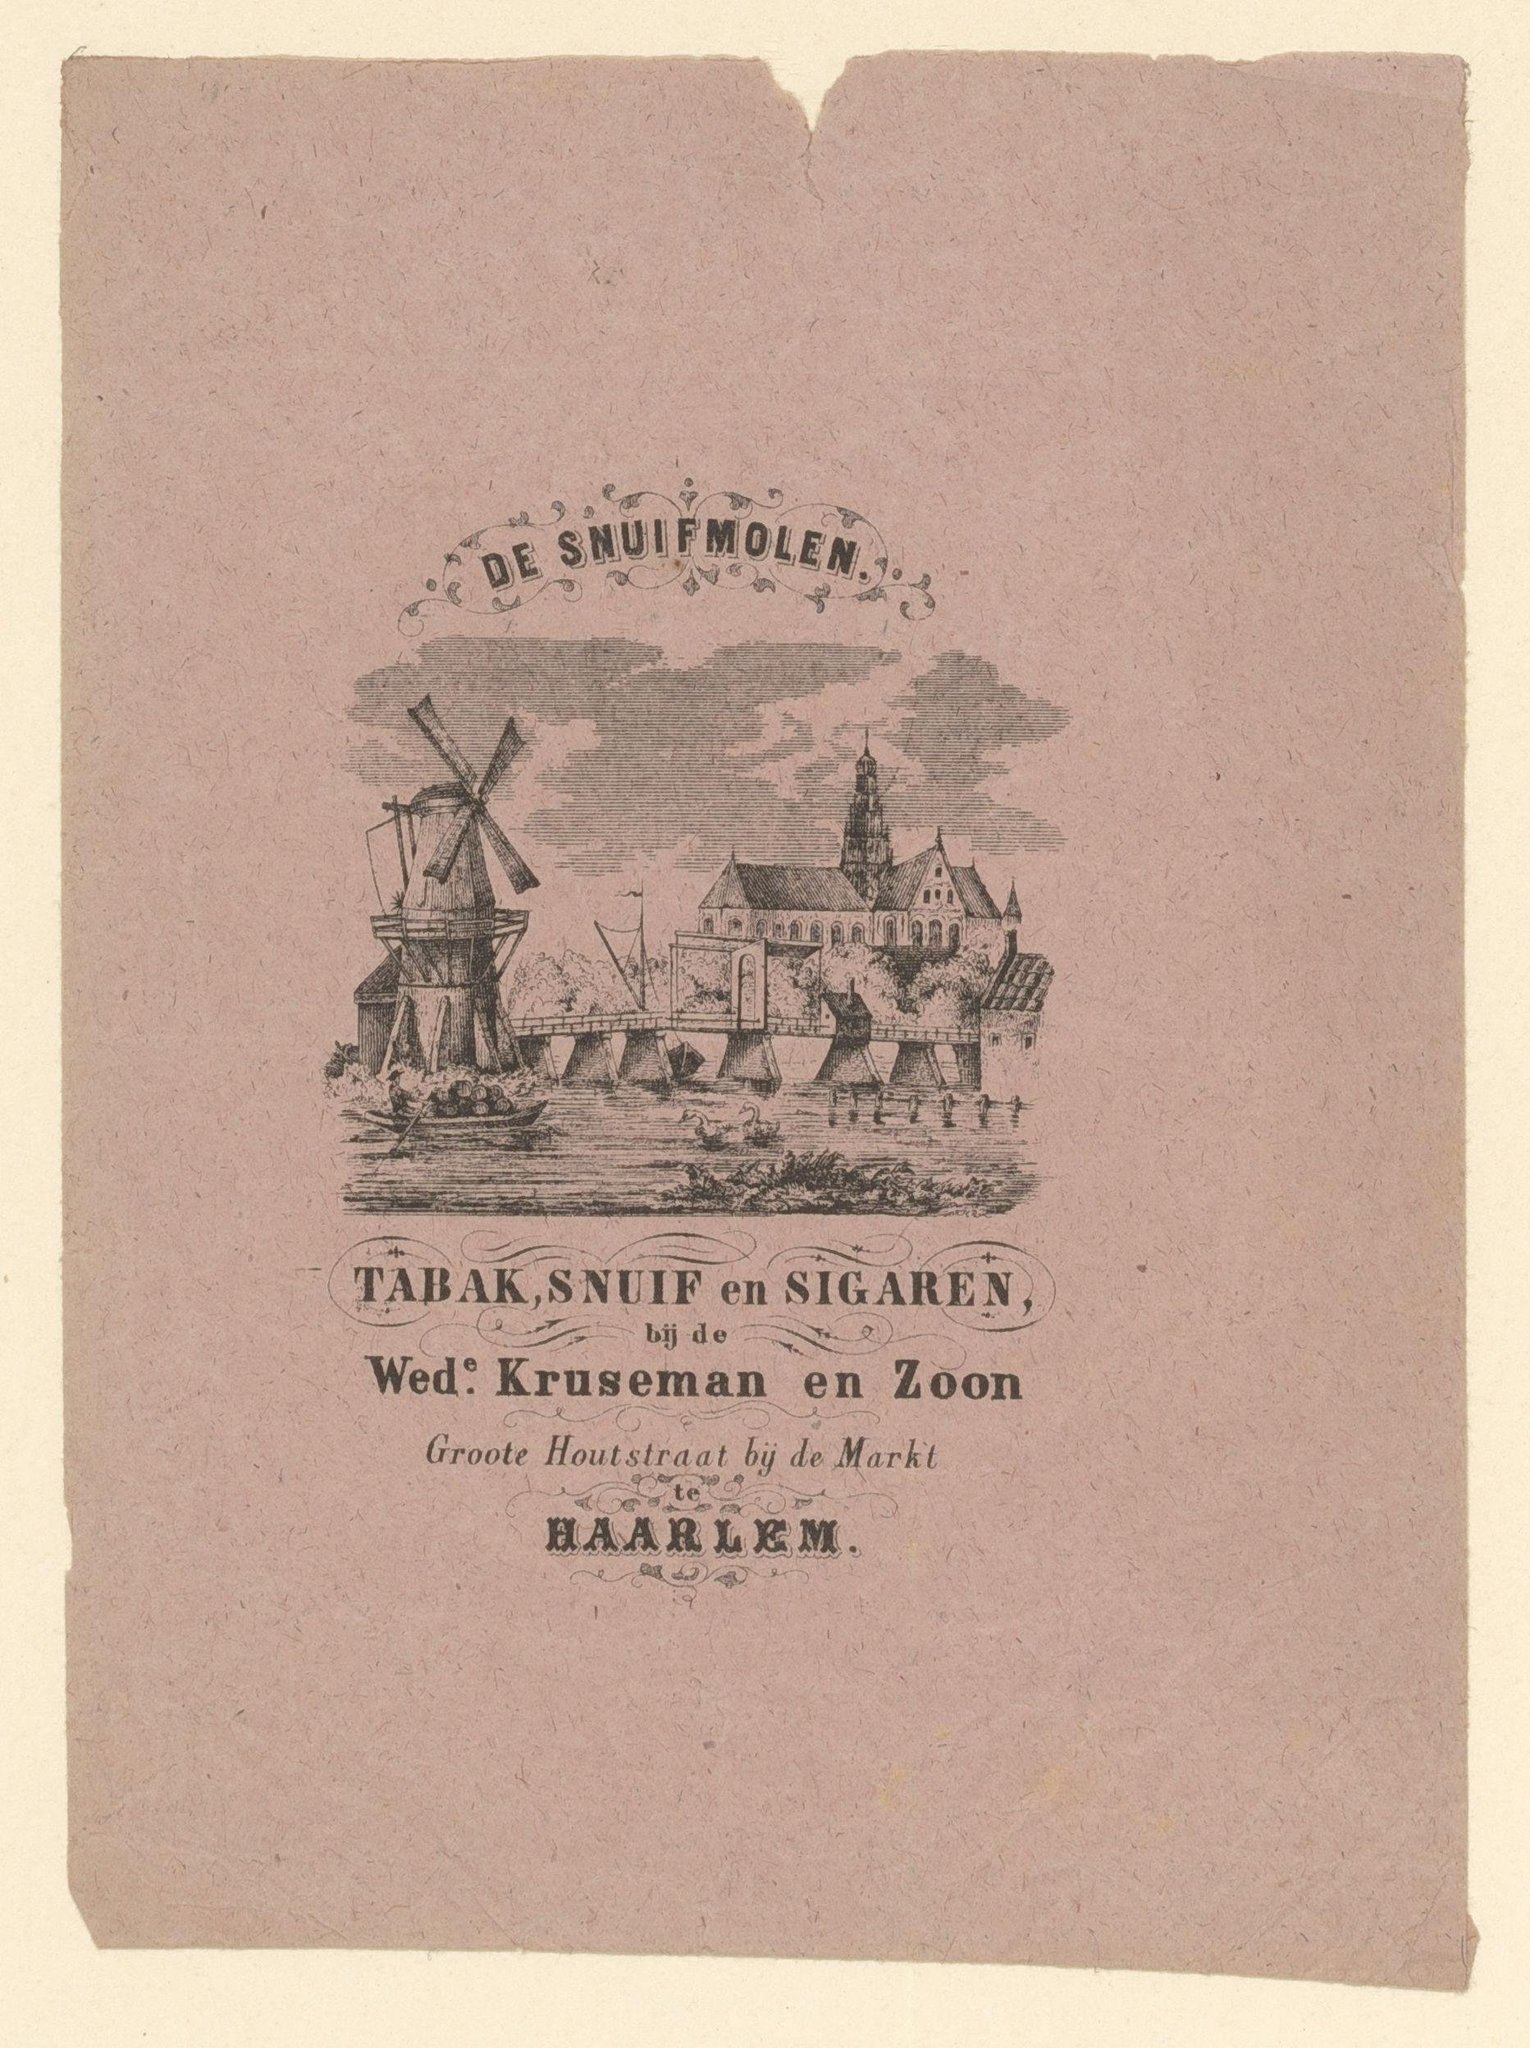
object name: print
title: Etiket voor tabaksverpakking van De Snuifmolen van de Weduwe Kruseman en Zoon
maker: Anonymous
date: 1800-1850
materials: paper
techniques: lithograph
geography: netherlands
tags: windmill, tobacco, haarlem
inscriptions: collector's mark, collector's mark: Lugt 1641